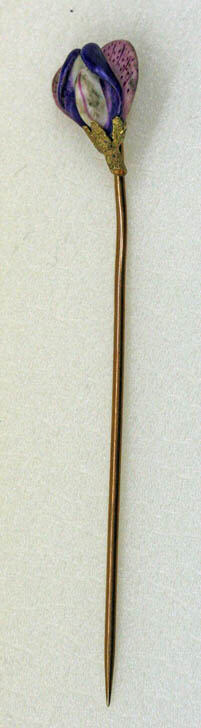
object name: pin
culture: american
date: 1891